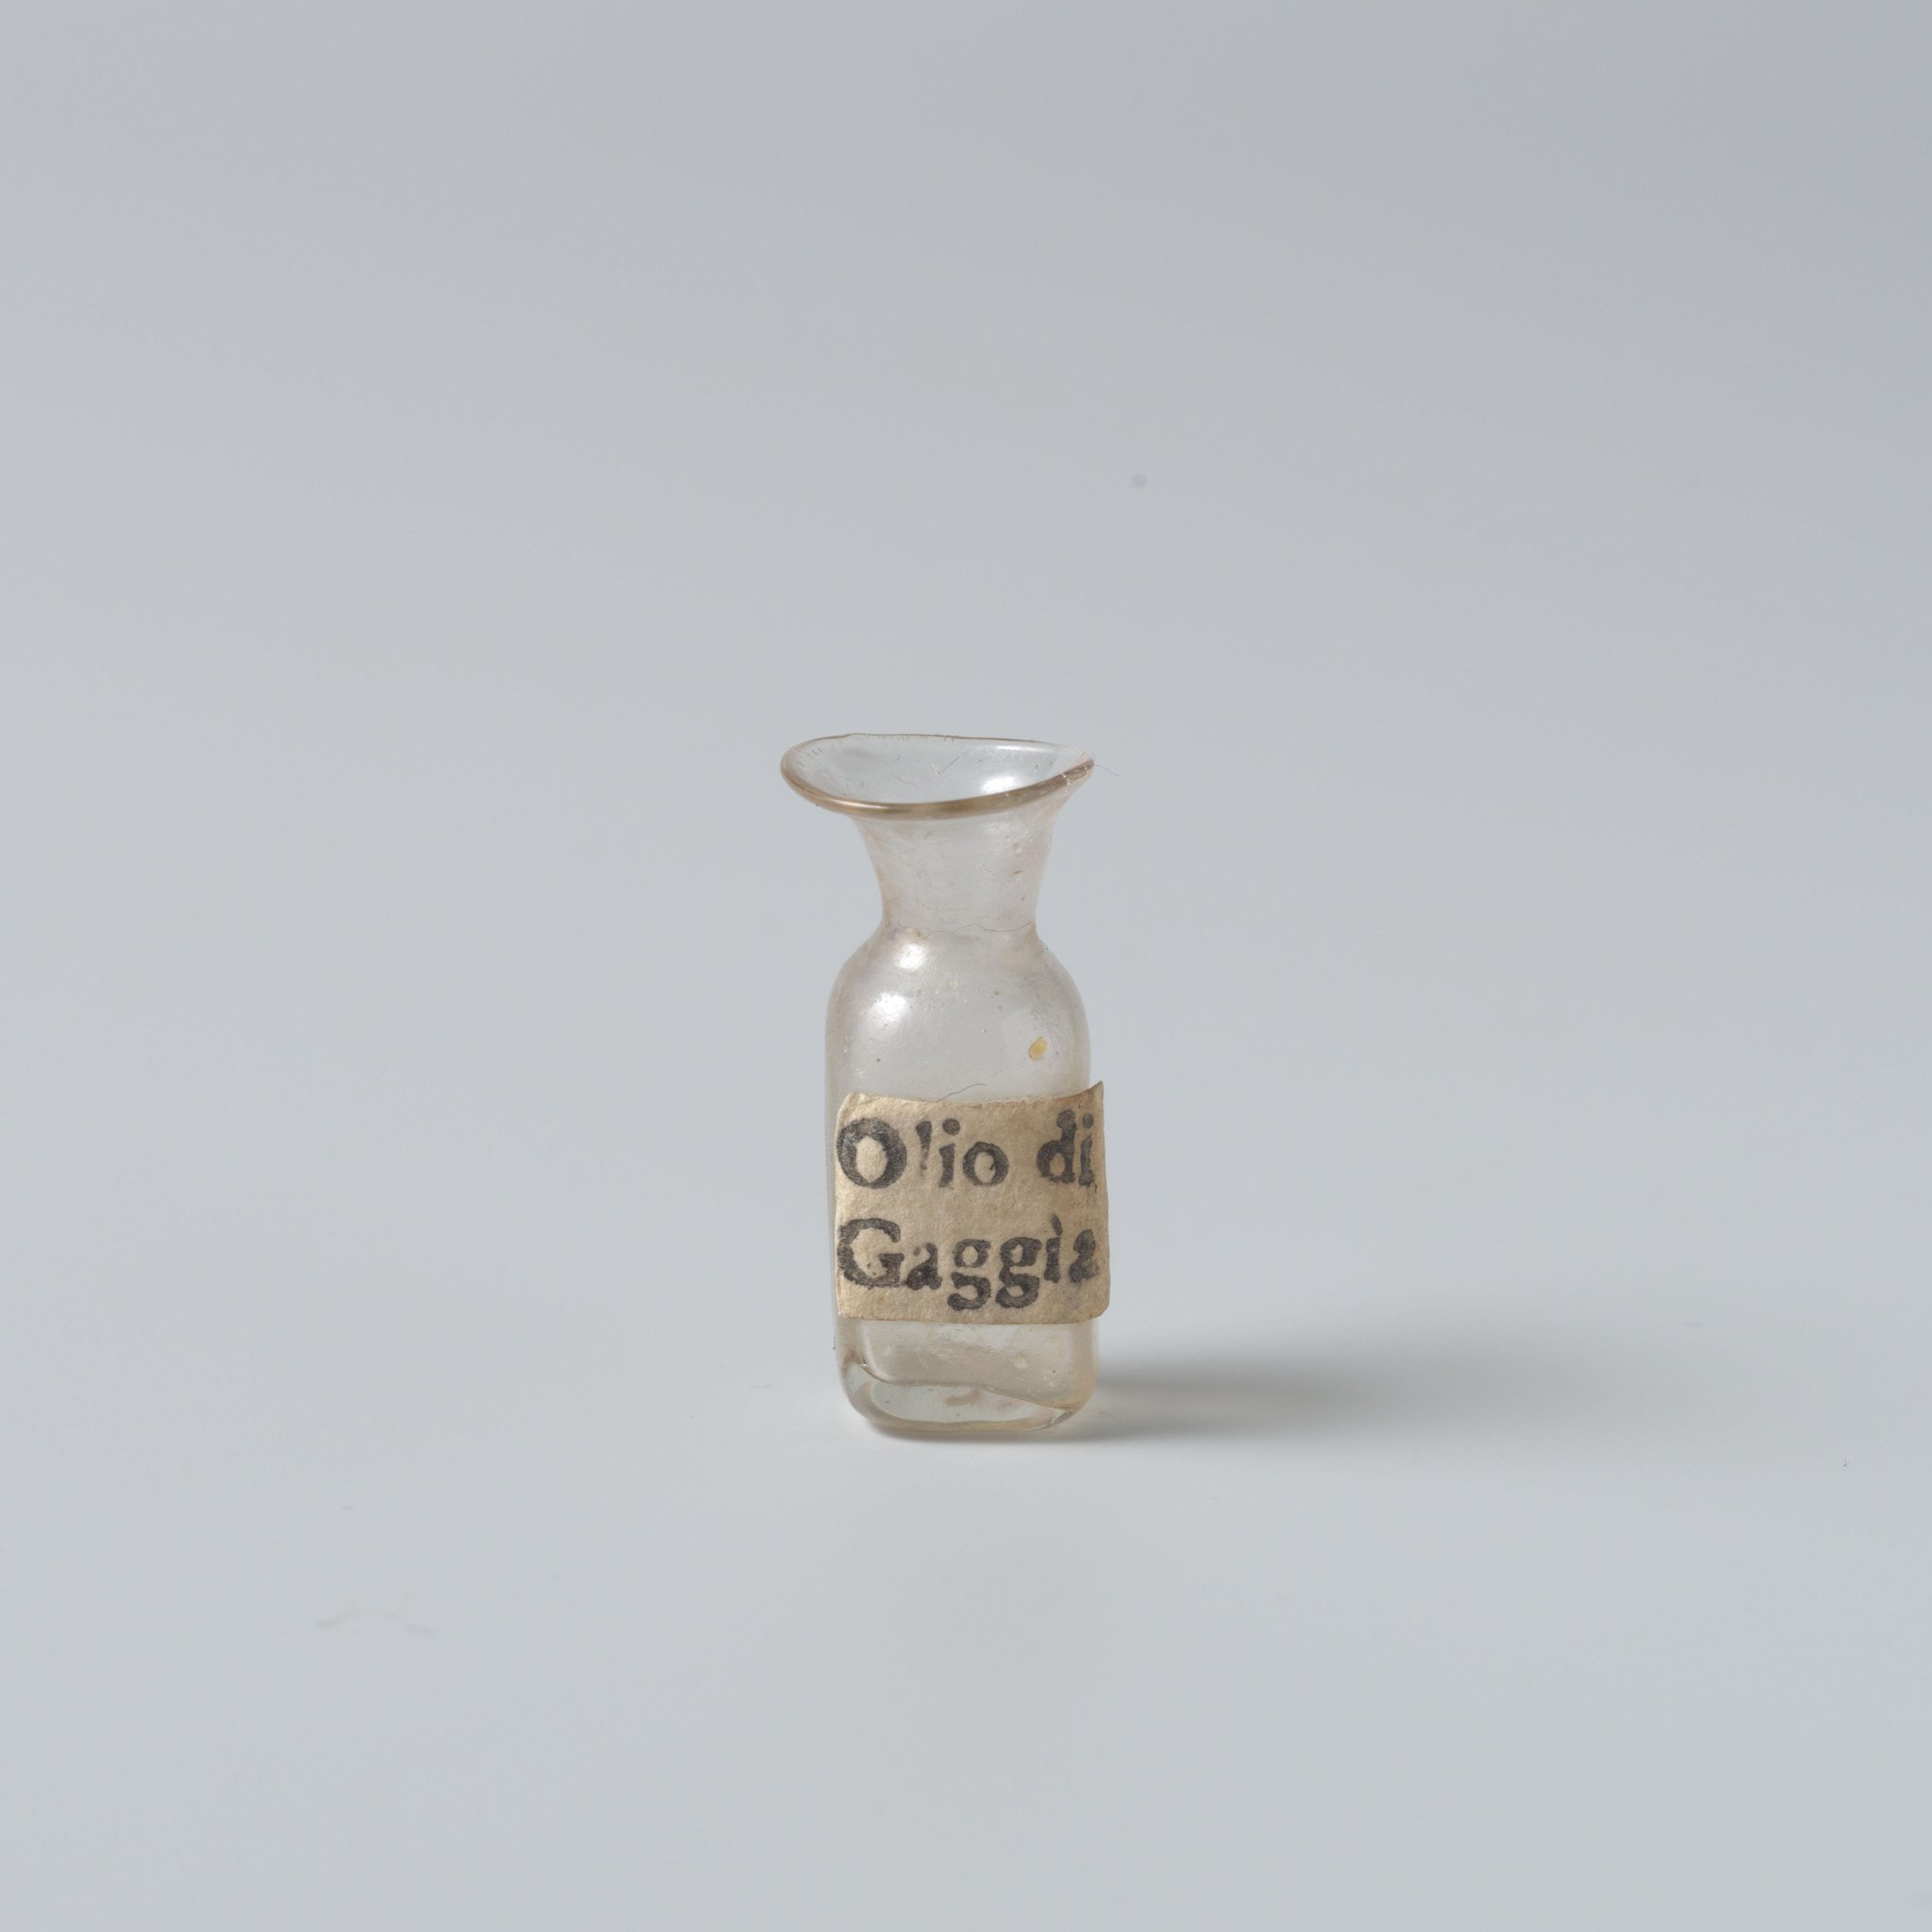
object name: miniature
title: Voorraadfles met vierkant lichaam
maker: Anonymous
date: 1700-1799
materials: glass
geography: netherlands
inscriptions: inscription: ‘Olio di Gaggia’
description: Voorraadfles van helder kleurloos glas, vierkant lichaam met hals en ronde wijduitstaande mondrand. De fles draagt een etiket met het opschrift: 'Olio di Gaggia'.